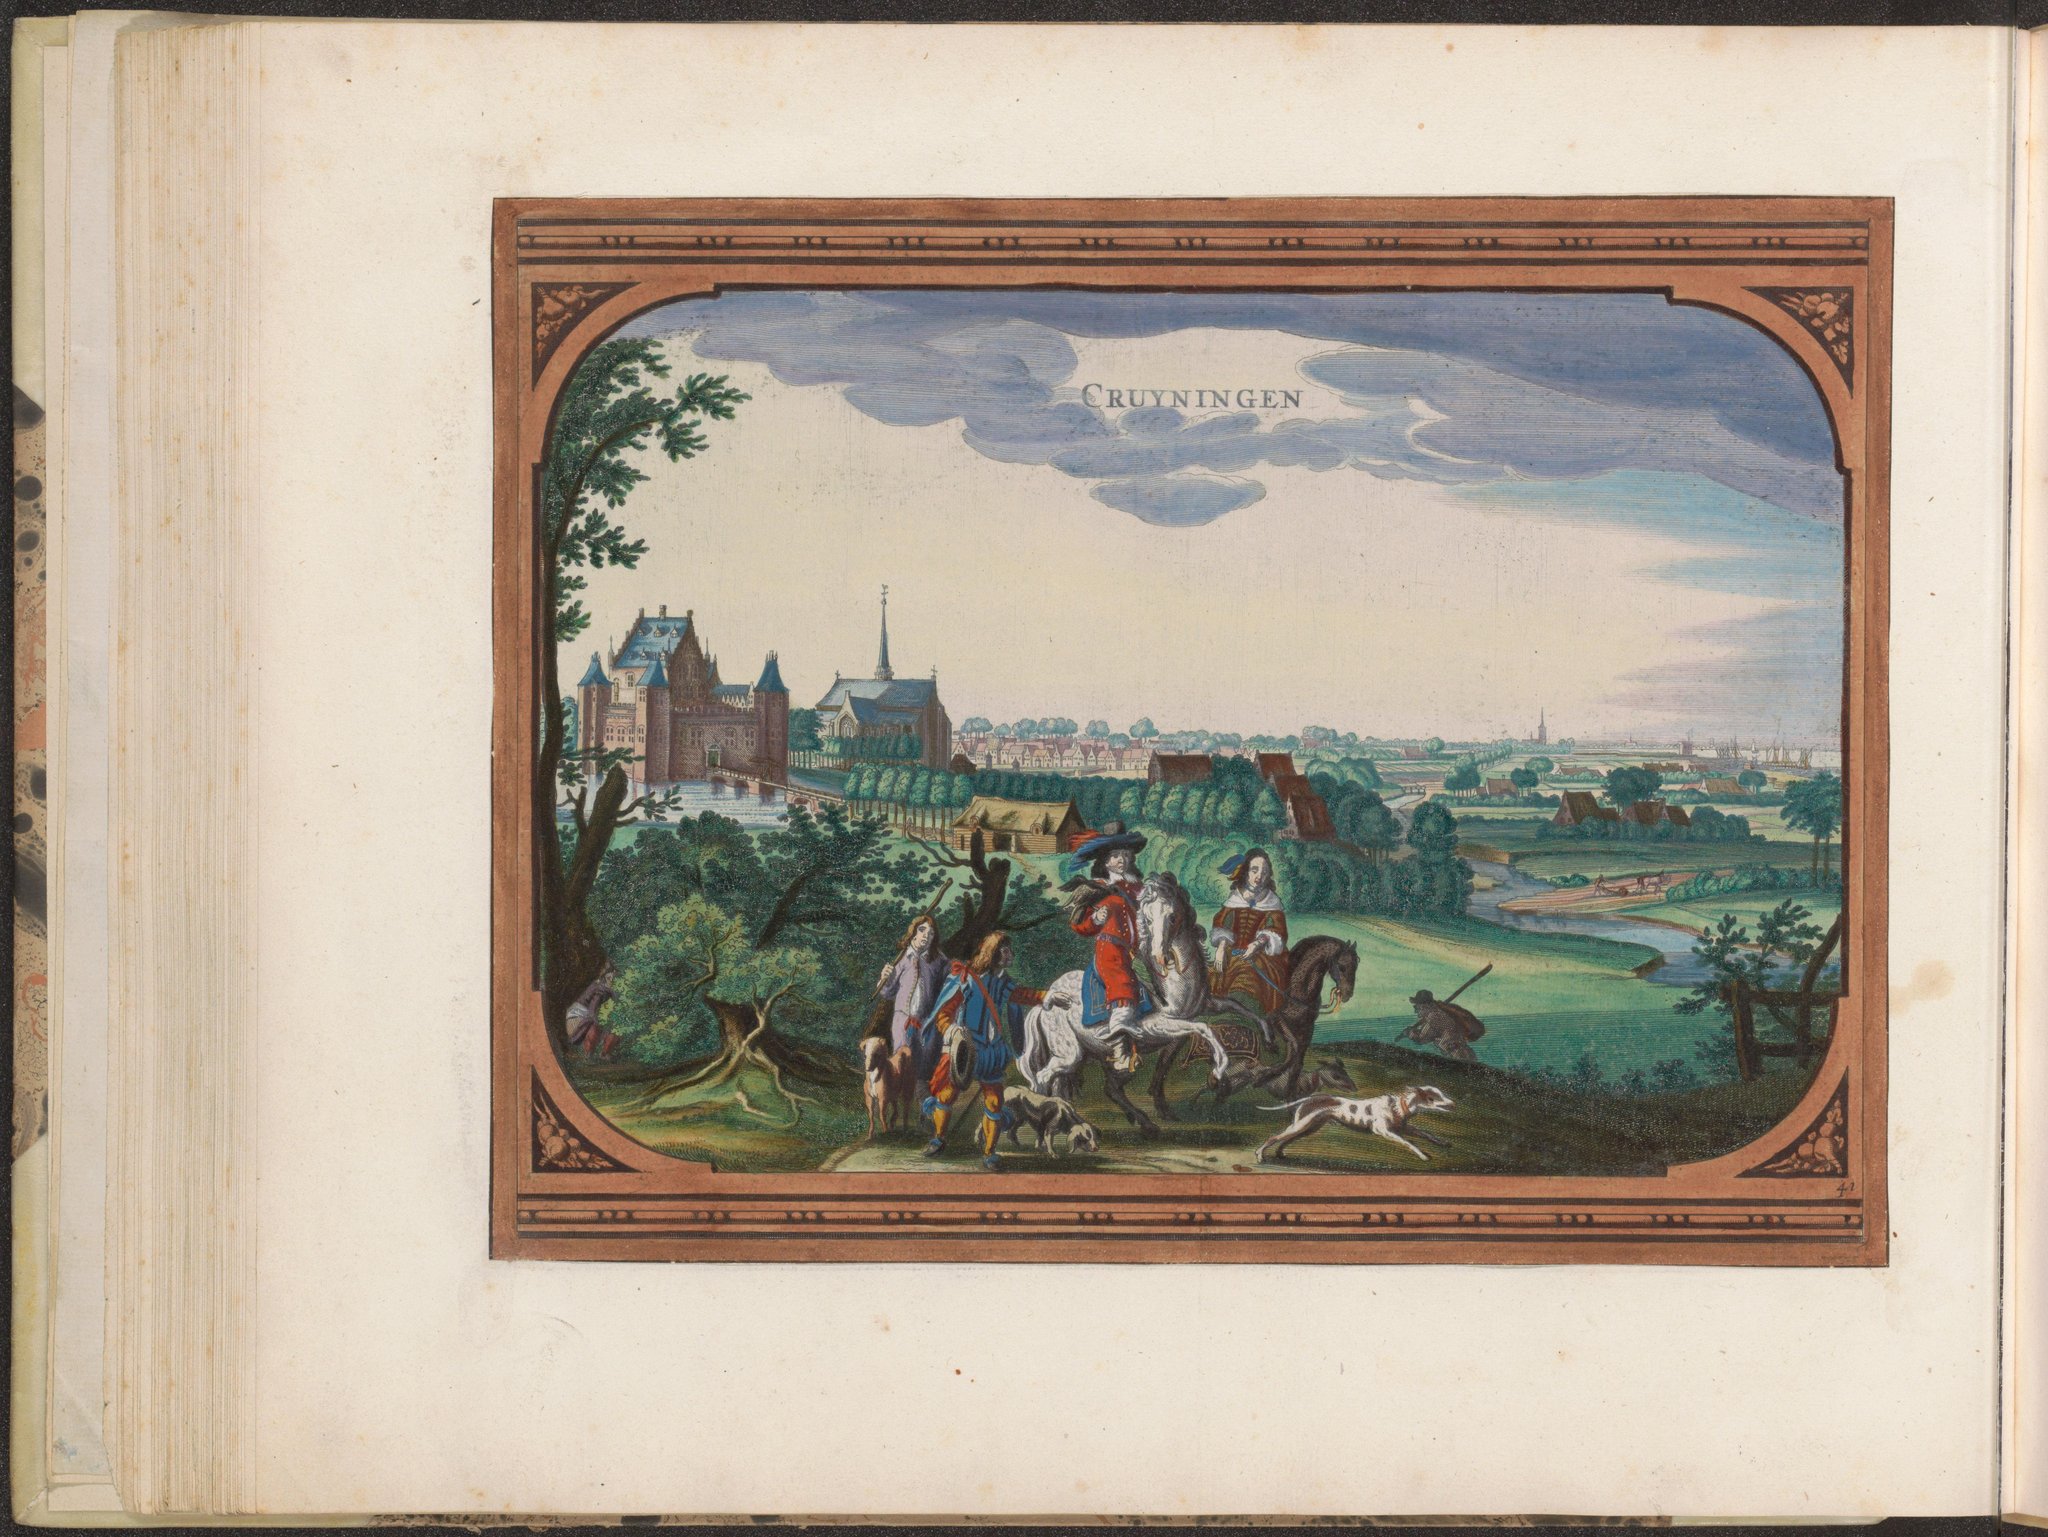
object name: album leaf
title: Theatrum praecipuarum urbium ducatus Brabantiae necnon comitatuum Flandriae et Zelandiae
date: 1662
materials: paper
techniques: etching, hand coloring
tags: city-view, and landscape with man-made constructions, castle, hunting, chase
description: Gezicht op Kruiningen in Zeeland. Op de voorgrond een welgesteld paar te paard. De man heeft twee jachthonden en een valk bij zich. Twee mannen wijzen het paar de weg. De prent maakt deel uit van een album.